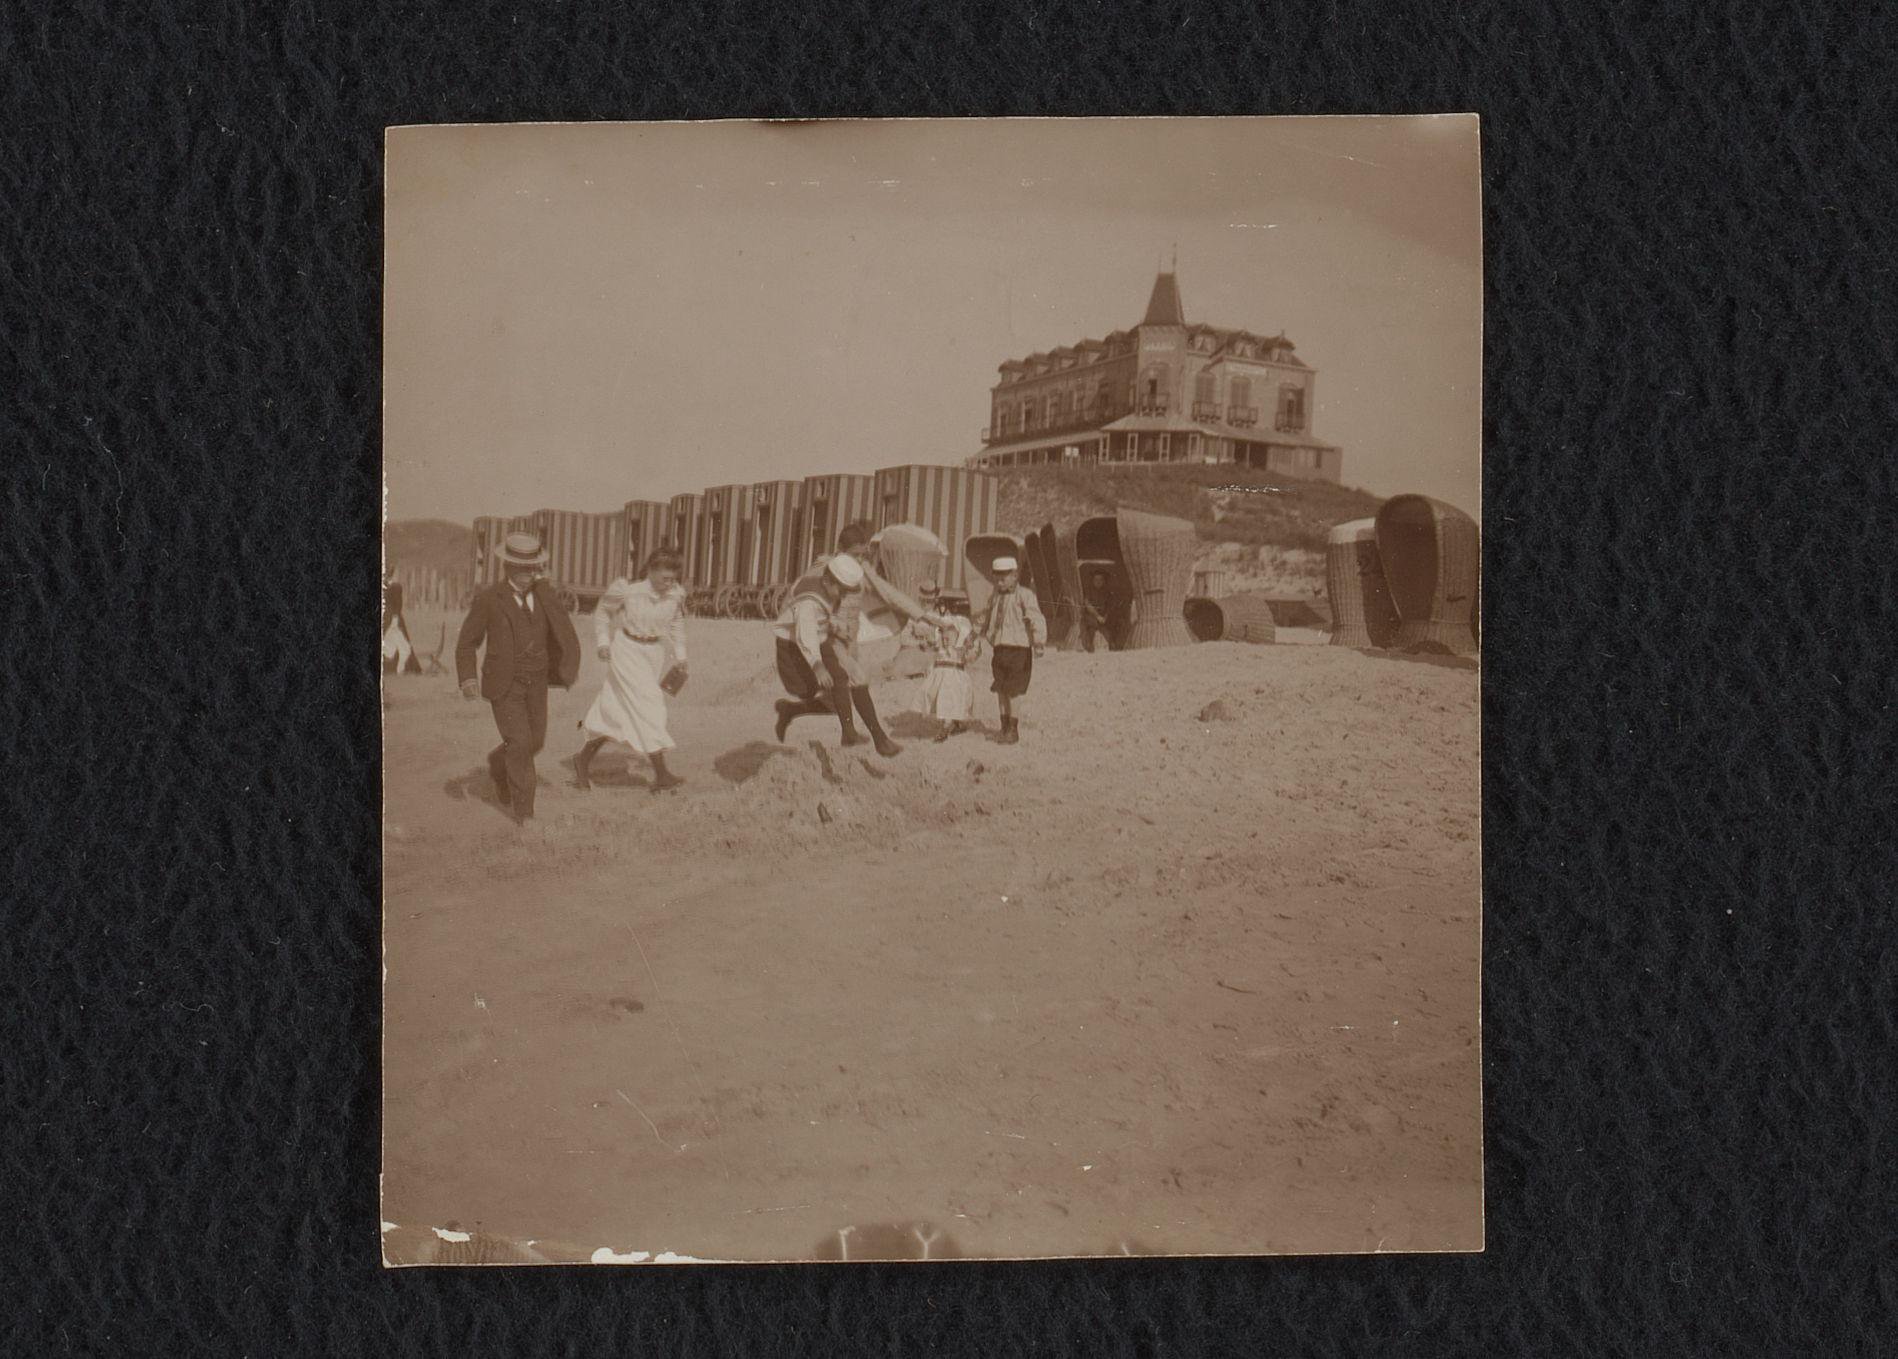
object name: photograph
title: Gezin van August Kessler op een strand, met Go, Boelie, Dolph, Guus en Jan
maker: jean baptiste august kessler (1853-1900)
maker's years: 1853-1900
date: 1898-1900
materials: paper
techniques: collodion silver print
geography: netherlands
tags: the hague, engineer, jean baptiste august kessler (1888-1972), johan herman kessler (jan), geldolph adriaan kessler (dolph), naples, jean baptiste august kessler (1853-1900), hermann johannes kessler (boelie), beach (as place of recreation), family life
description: Uit envelop van Hendrik A. Matthes (1861 – 1919; Keizersgracht 756, Amsterdam), met opschrift van een van de kinderen van August Kessler (1853-1900): 'Photo's die Papaatje bij zich had.'